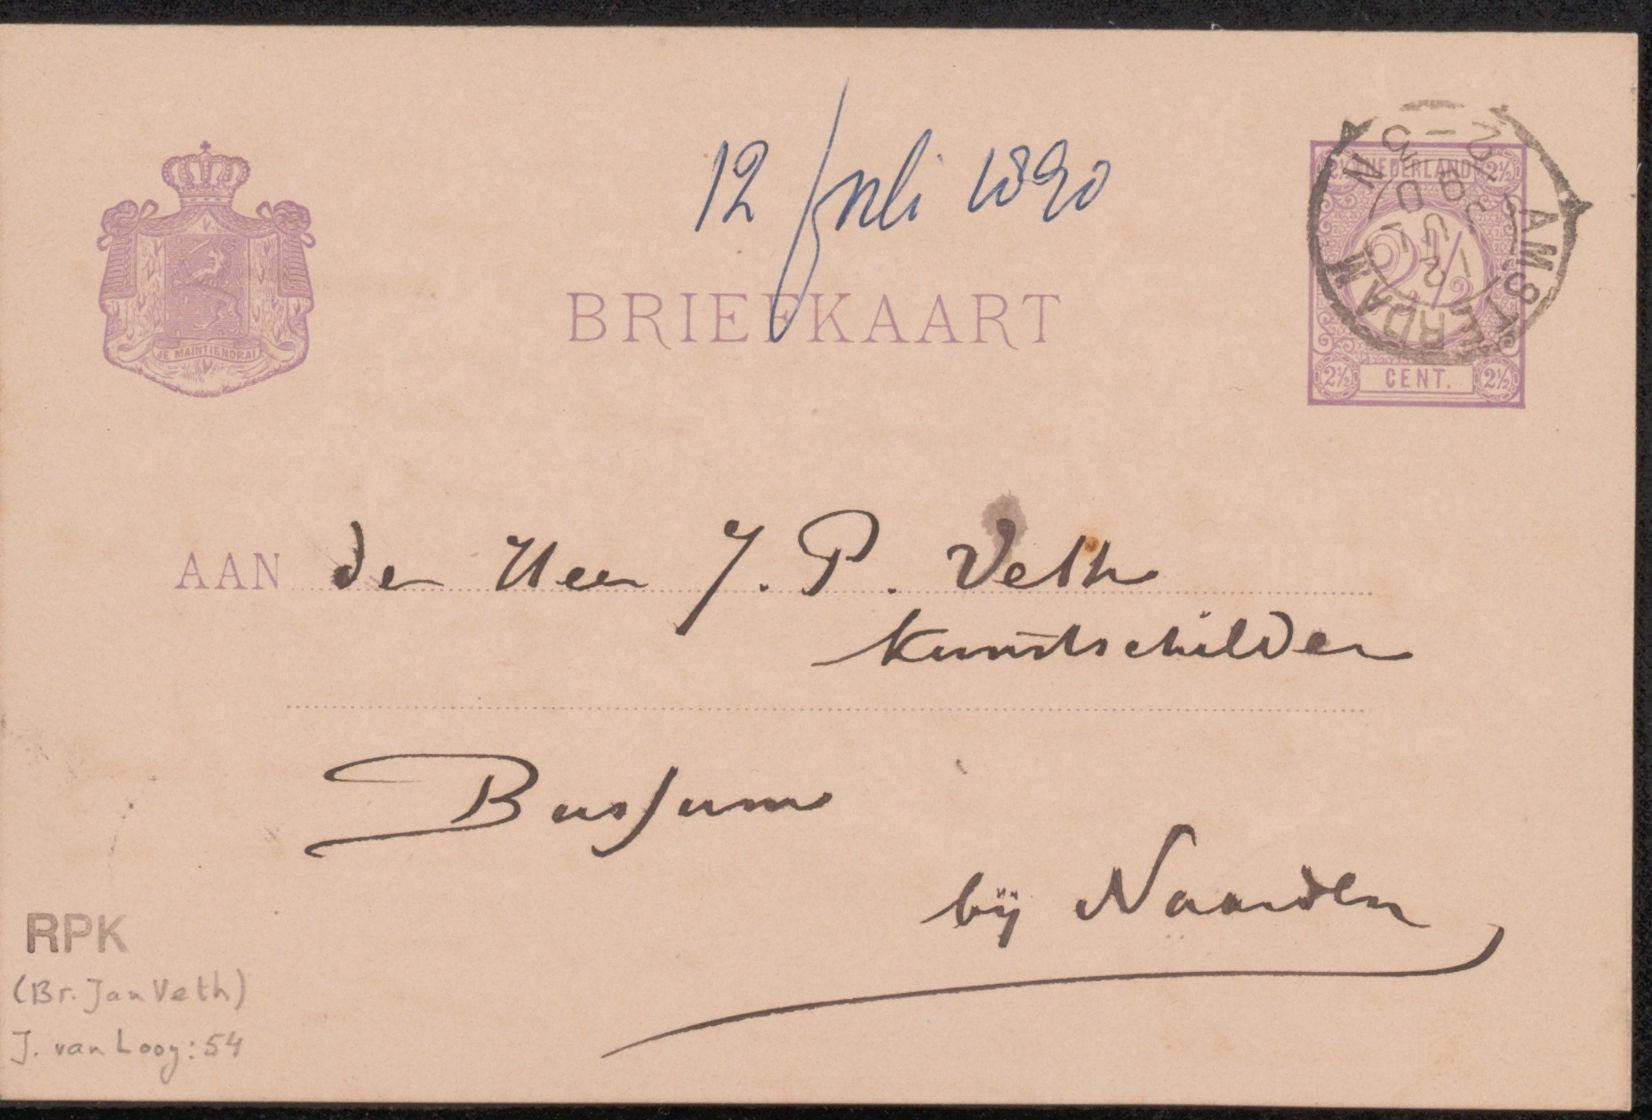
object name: postcard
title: Briefkaart aan Jan Veth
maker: jac van looij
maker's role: draughtsman, painter, print maker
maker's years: 1855-1930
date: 1890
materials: cardboard, ink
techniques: pen, writing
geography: amsterdam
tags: designer, jan veth, amsterdam, hein boeken, drawing, passions, emotions, affections, money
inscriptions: collector's mark: ‘RPK’